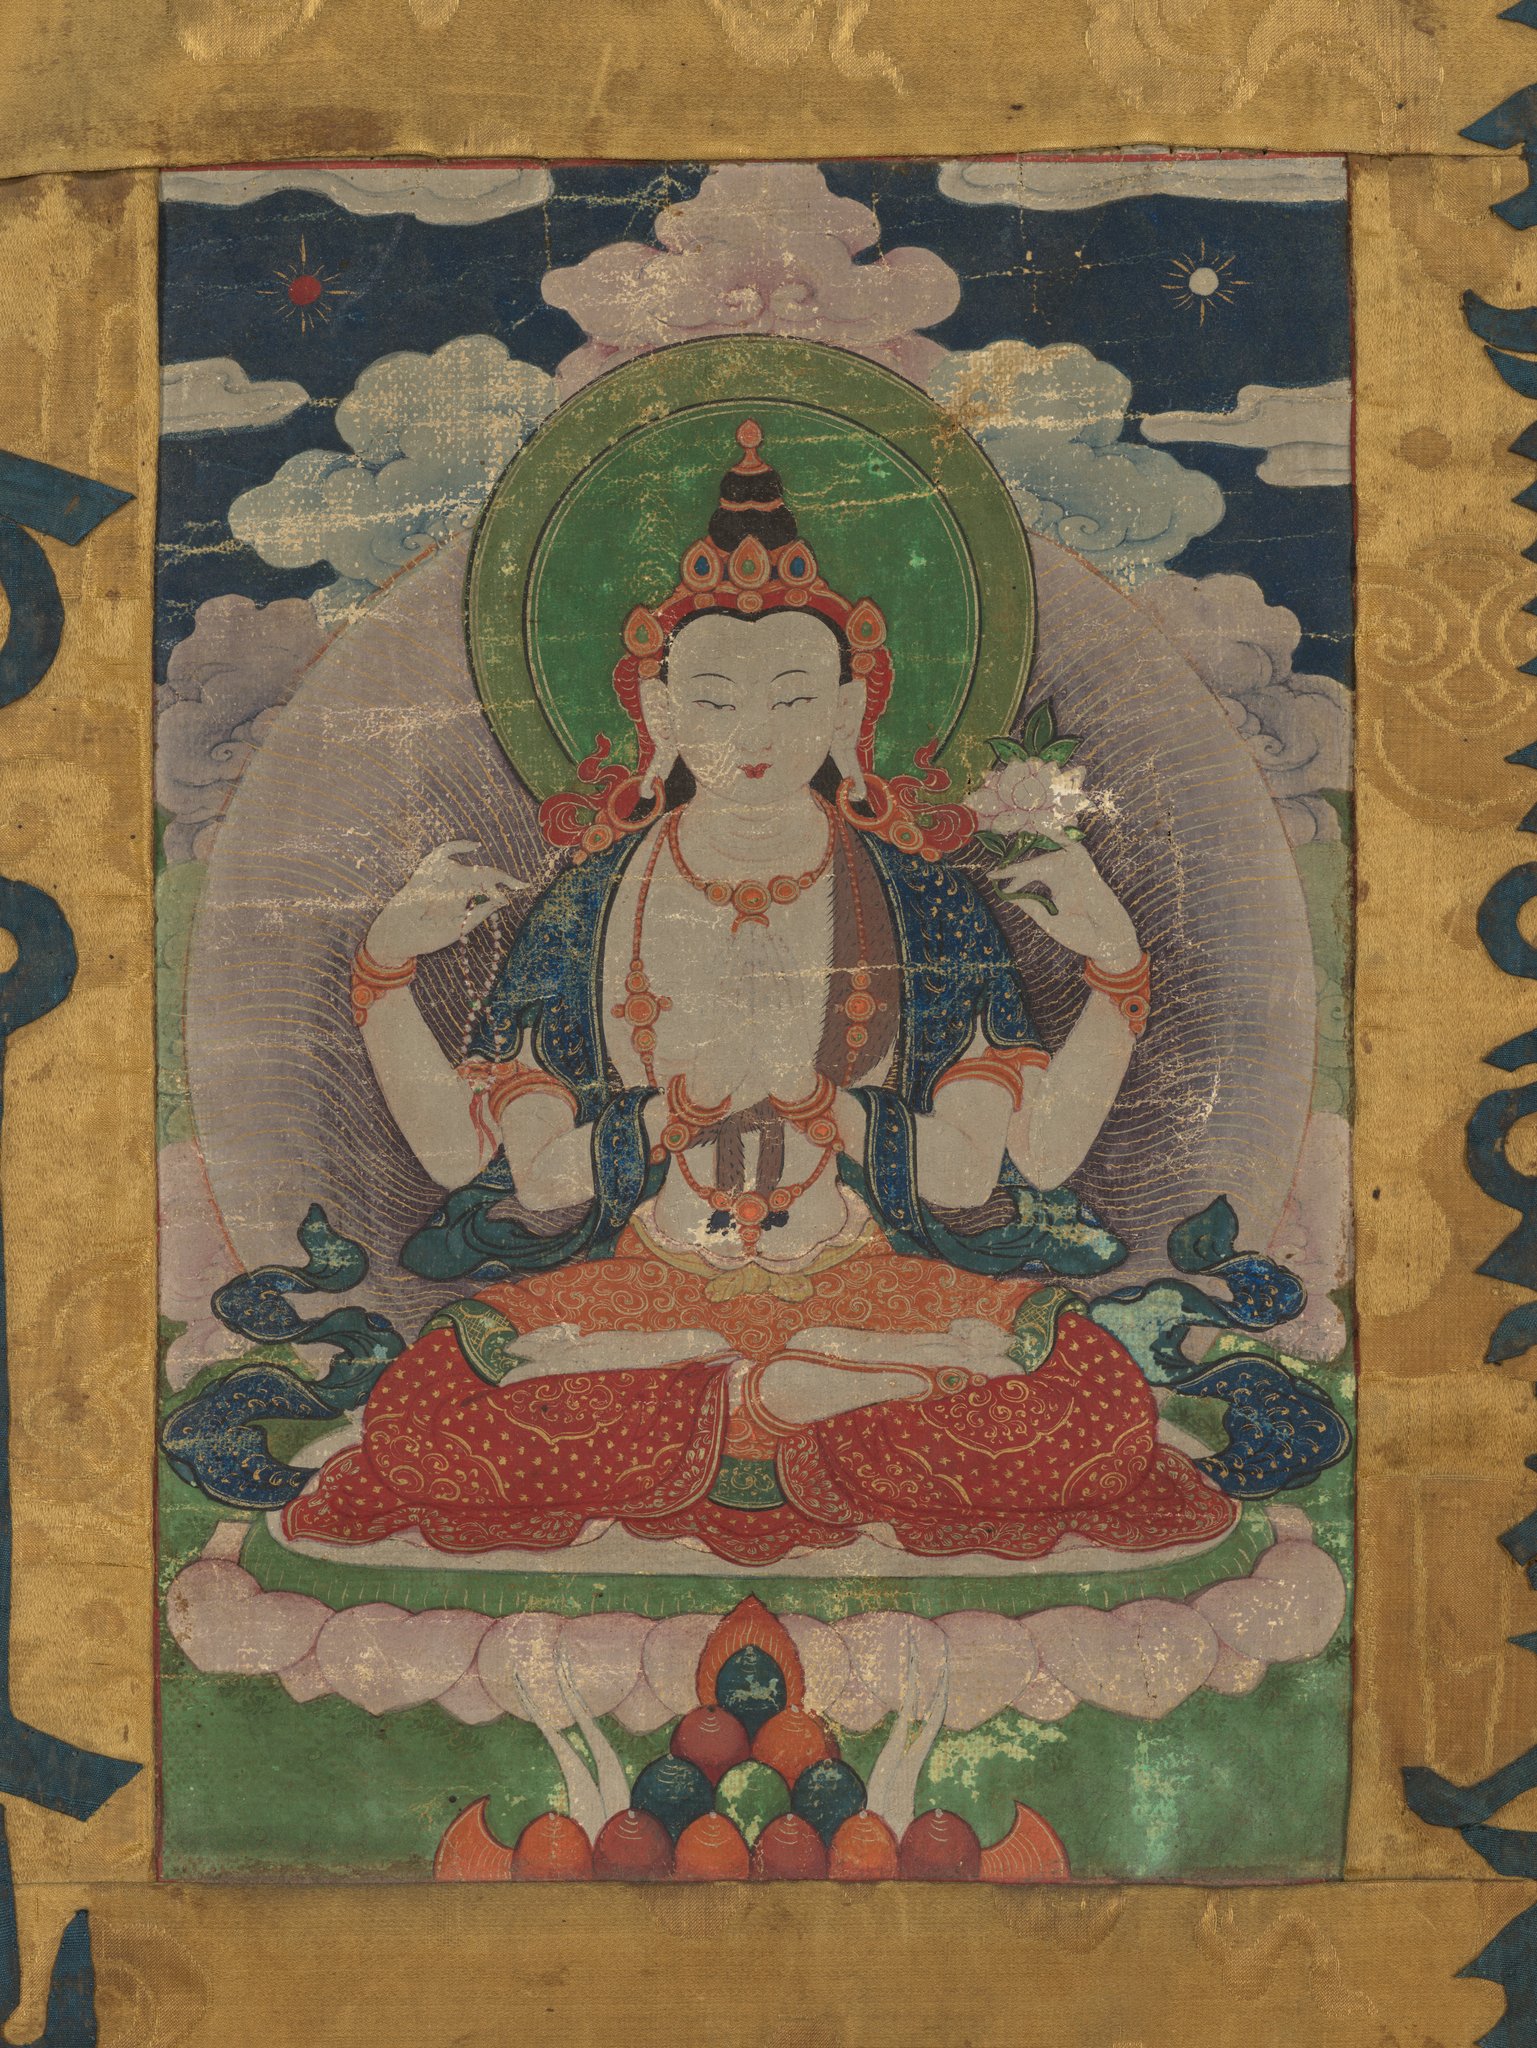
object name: hanging scroll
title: Hanging Scroll of Lama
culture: tibetan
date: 1601-1700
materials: textile, gold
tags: buddhism